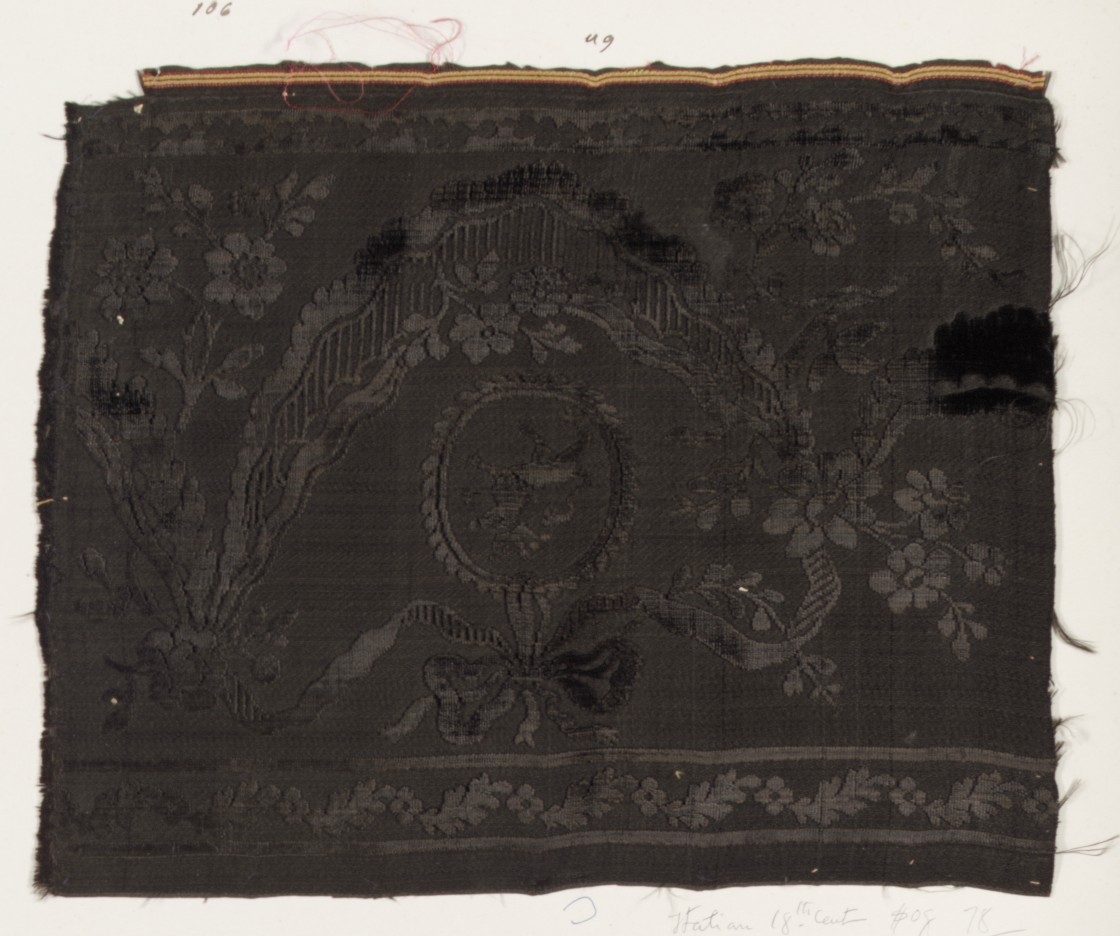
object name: fragment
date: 1701-1800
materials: silk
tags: flowers,leaves